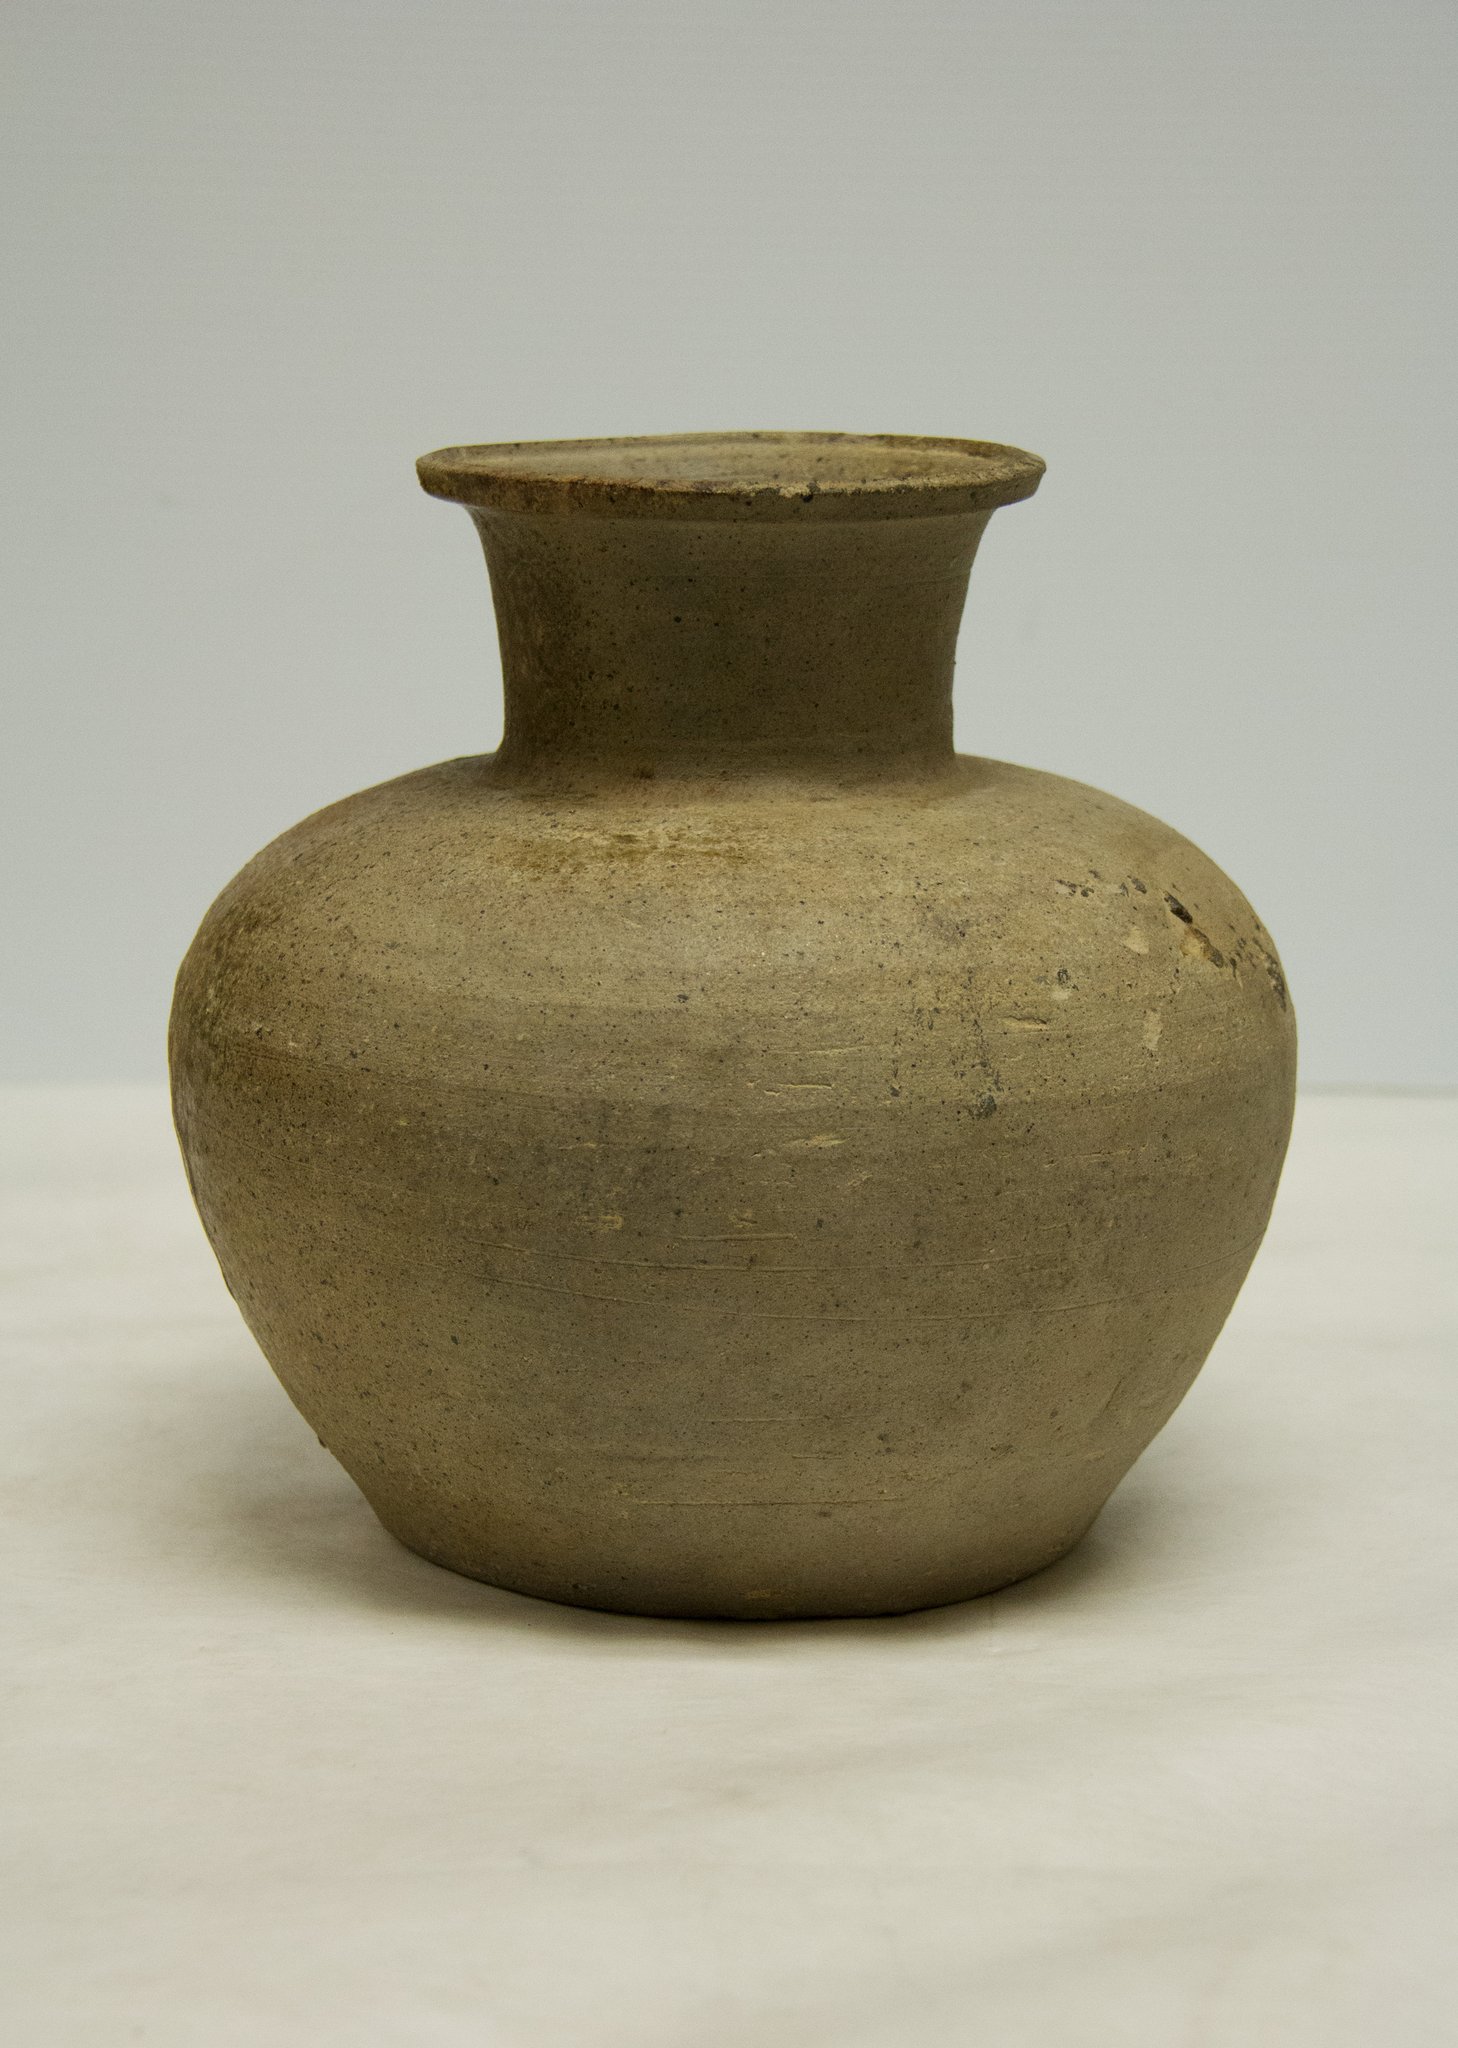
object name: jar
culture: japanese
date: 801-900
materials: wood, glaze, stoneware